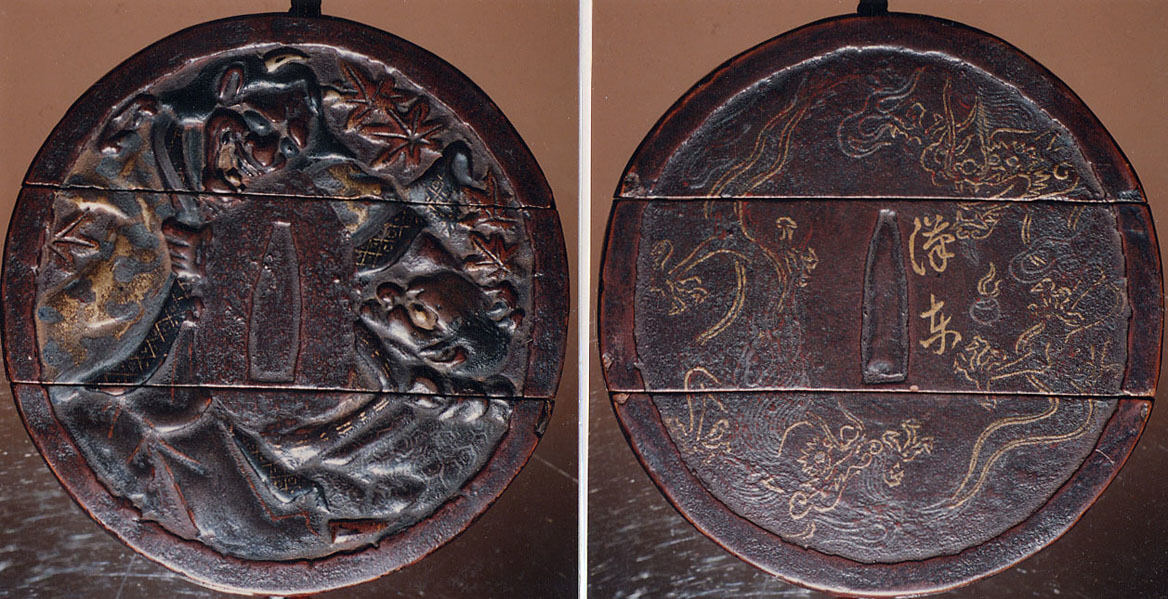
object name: inrō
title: Case (Inrō) with Design of Hannya and Anchin-san beside Maple Leaves (obverse); Flaming Dragons and Inscription (reverse)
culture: japanese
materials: gold, iron, lacquer, silver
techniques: fundame, hiramakie, roiro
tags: dragons,demons